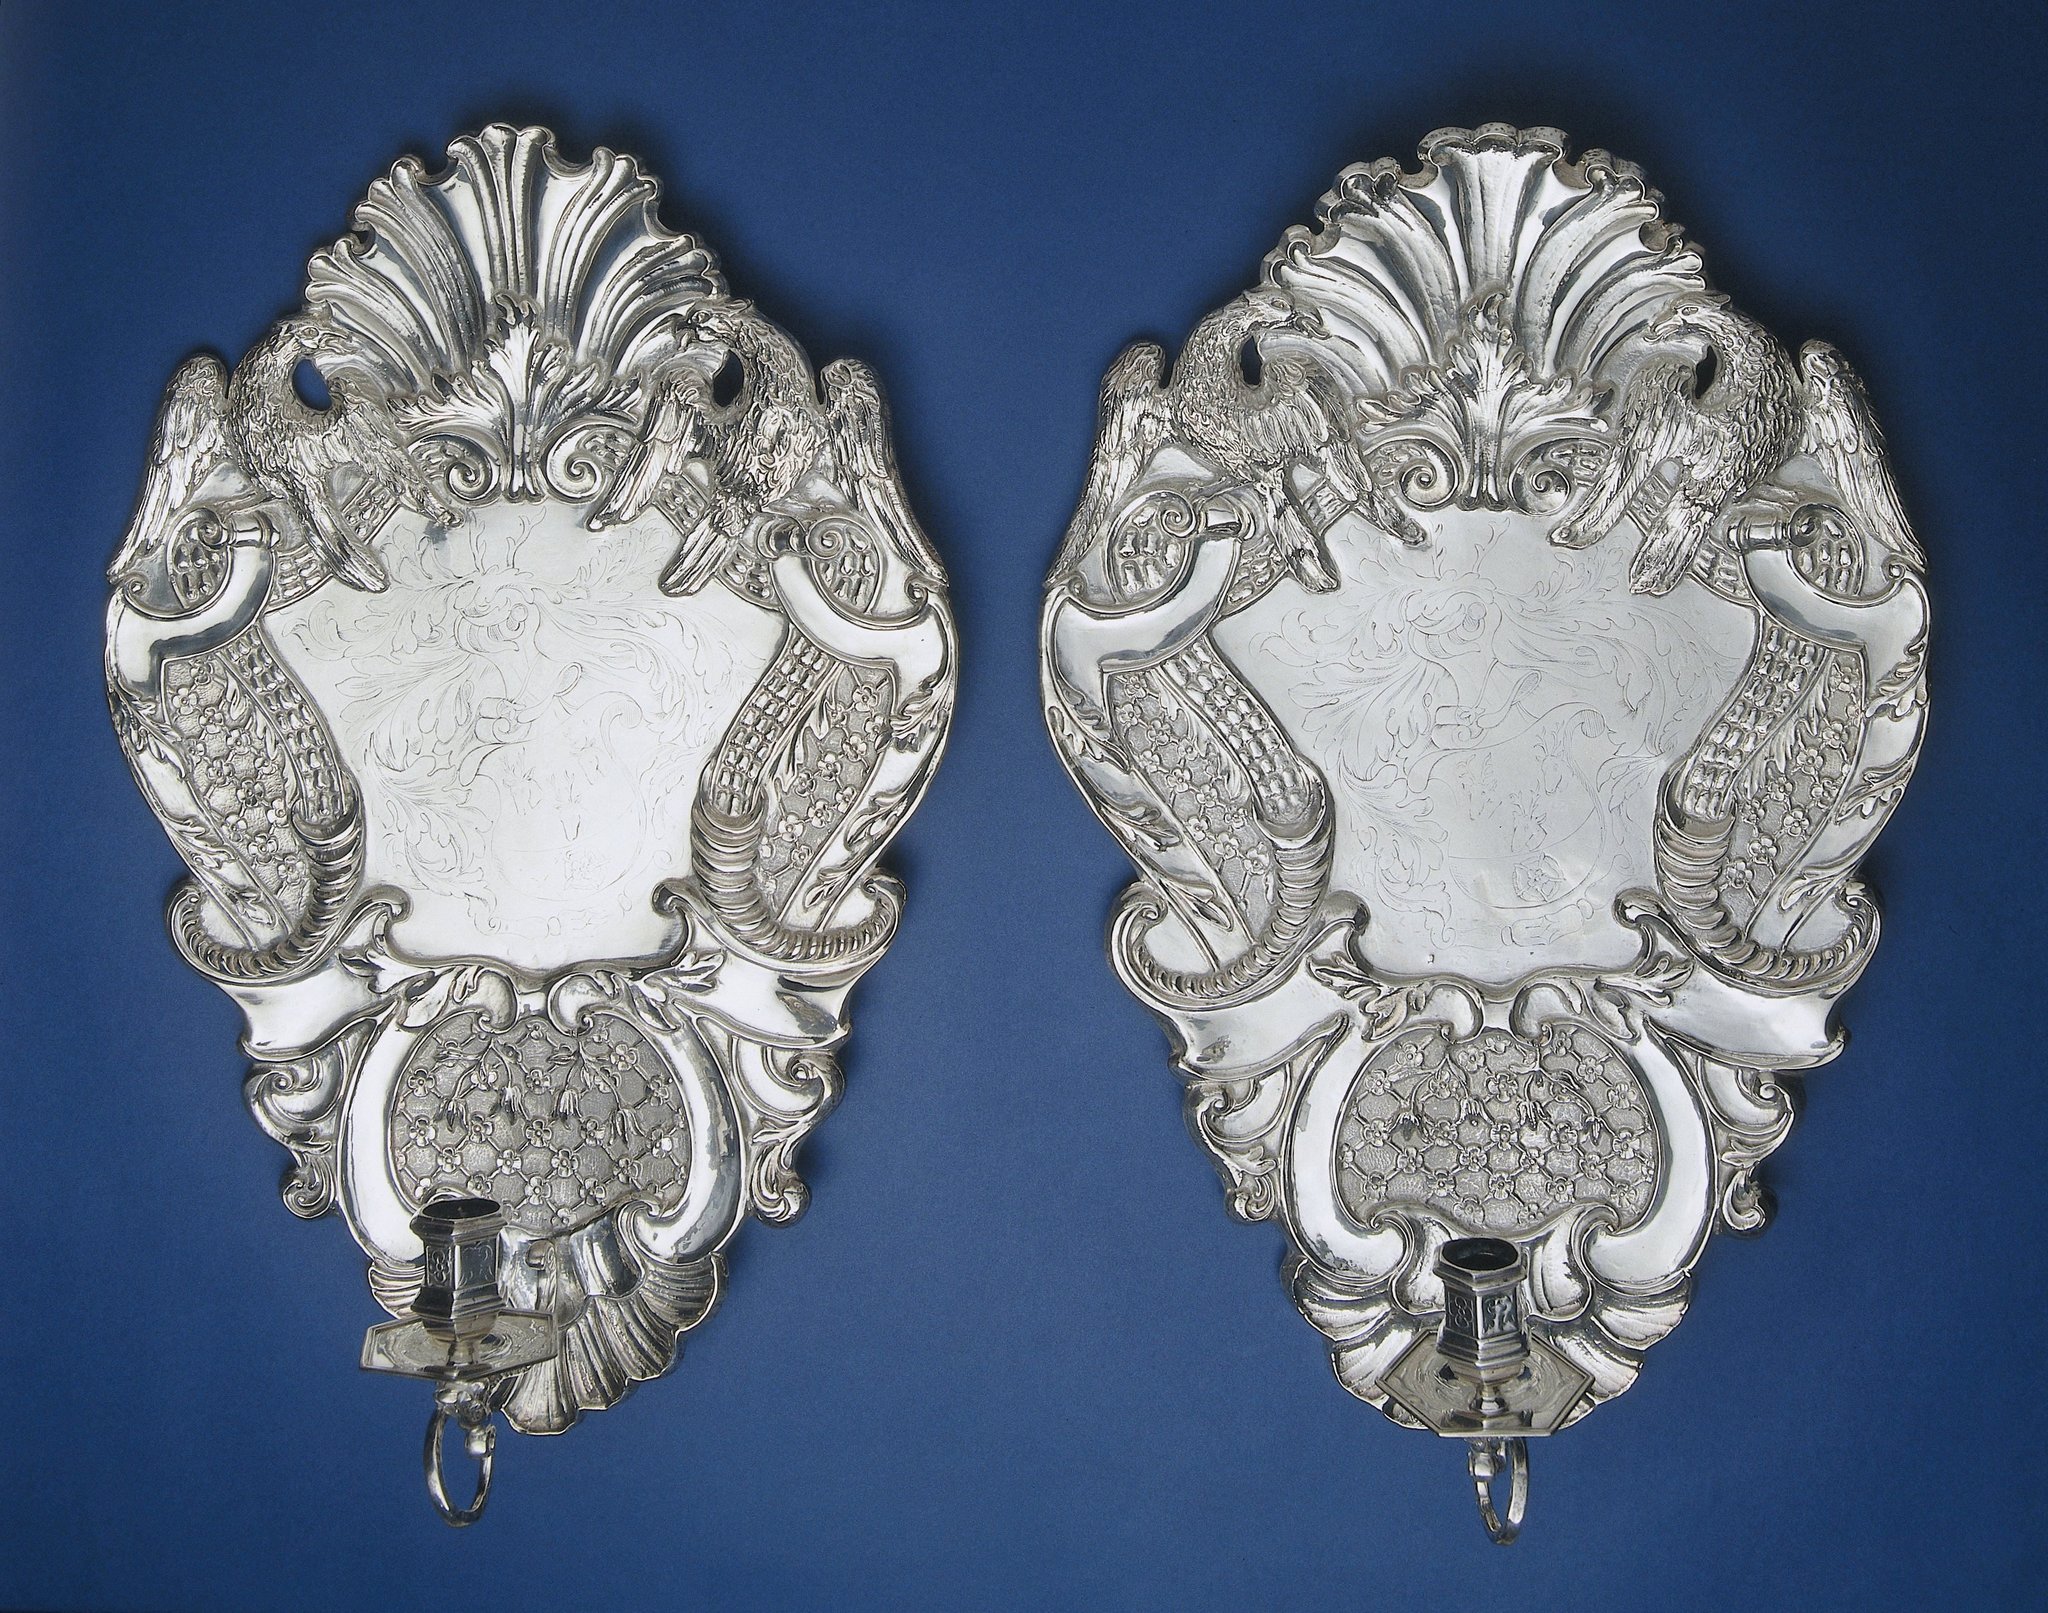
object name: wandblaker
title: Wandarm met achterplaat met het wapen van de familie Spiegel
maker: hendrik swierinck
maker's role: silversmith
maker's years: 1693-1772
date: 1745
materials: silver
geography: amsterdam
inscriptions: date letter: ‘L’, duty mark, alloy mark: ‘Hollandse leeuw’, town mark, maker's mark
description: Pair of wall sconces. Silver. Amsterdam, 1745, by Hendrik Swierink.